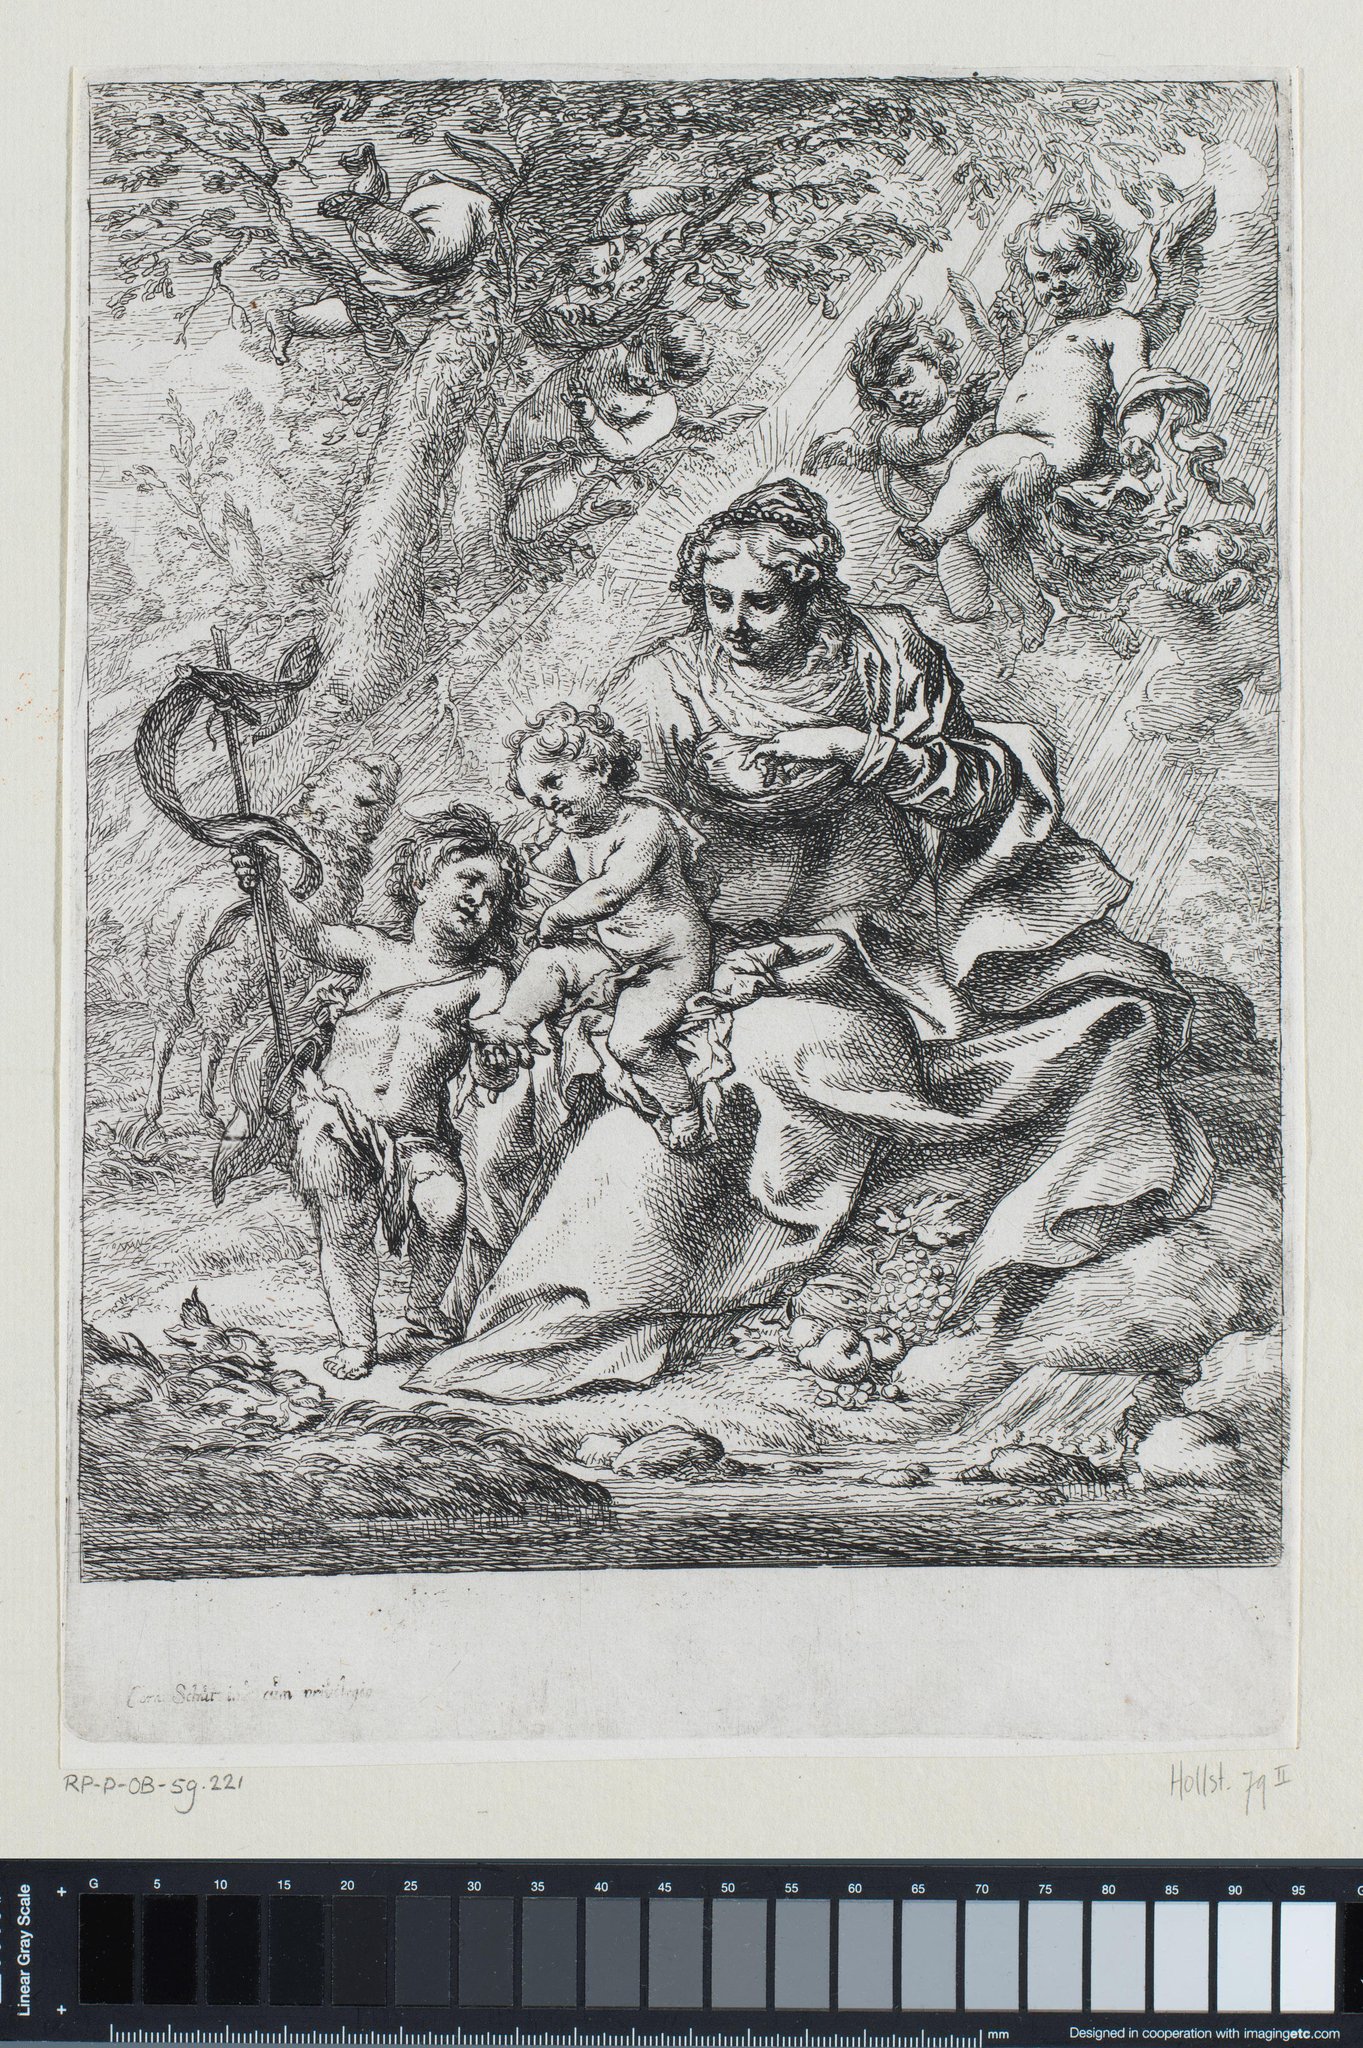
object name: print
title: Madonna met kind en Johannes de Doper in een landschap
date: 1618-1655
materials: paper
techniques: etching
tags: mary and the christ-child with john the baptist (as child)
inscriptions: collector's mark: Lugt 240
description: Maria zit op de grond onder een boom met het Christuskind op schoot. De jonge Johannes de Doper staat naast haar. In zijn hand houdt hij een overwinningsbanier. Met zijn andere hand houdt hij de voet van het kind vast. Boven Maria twee putti en een cherubijntje, in de boom twee putti.